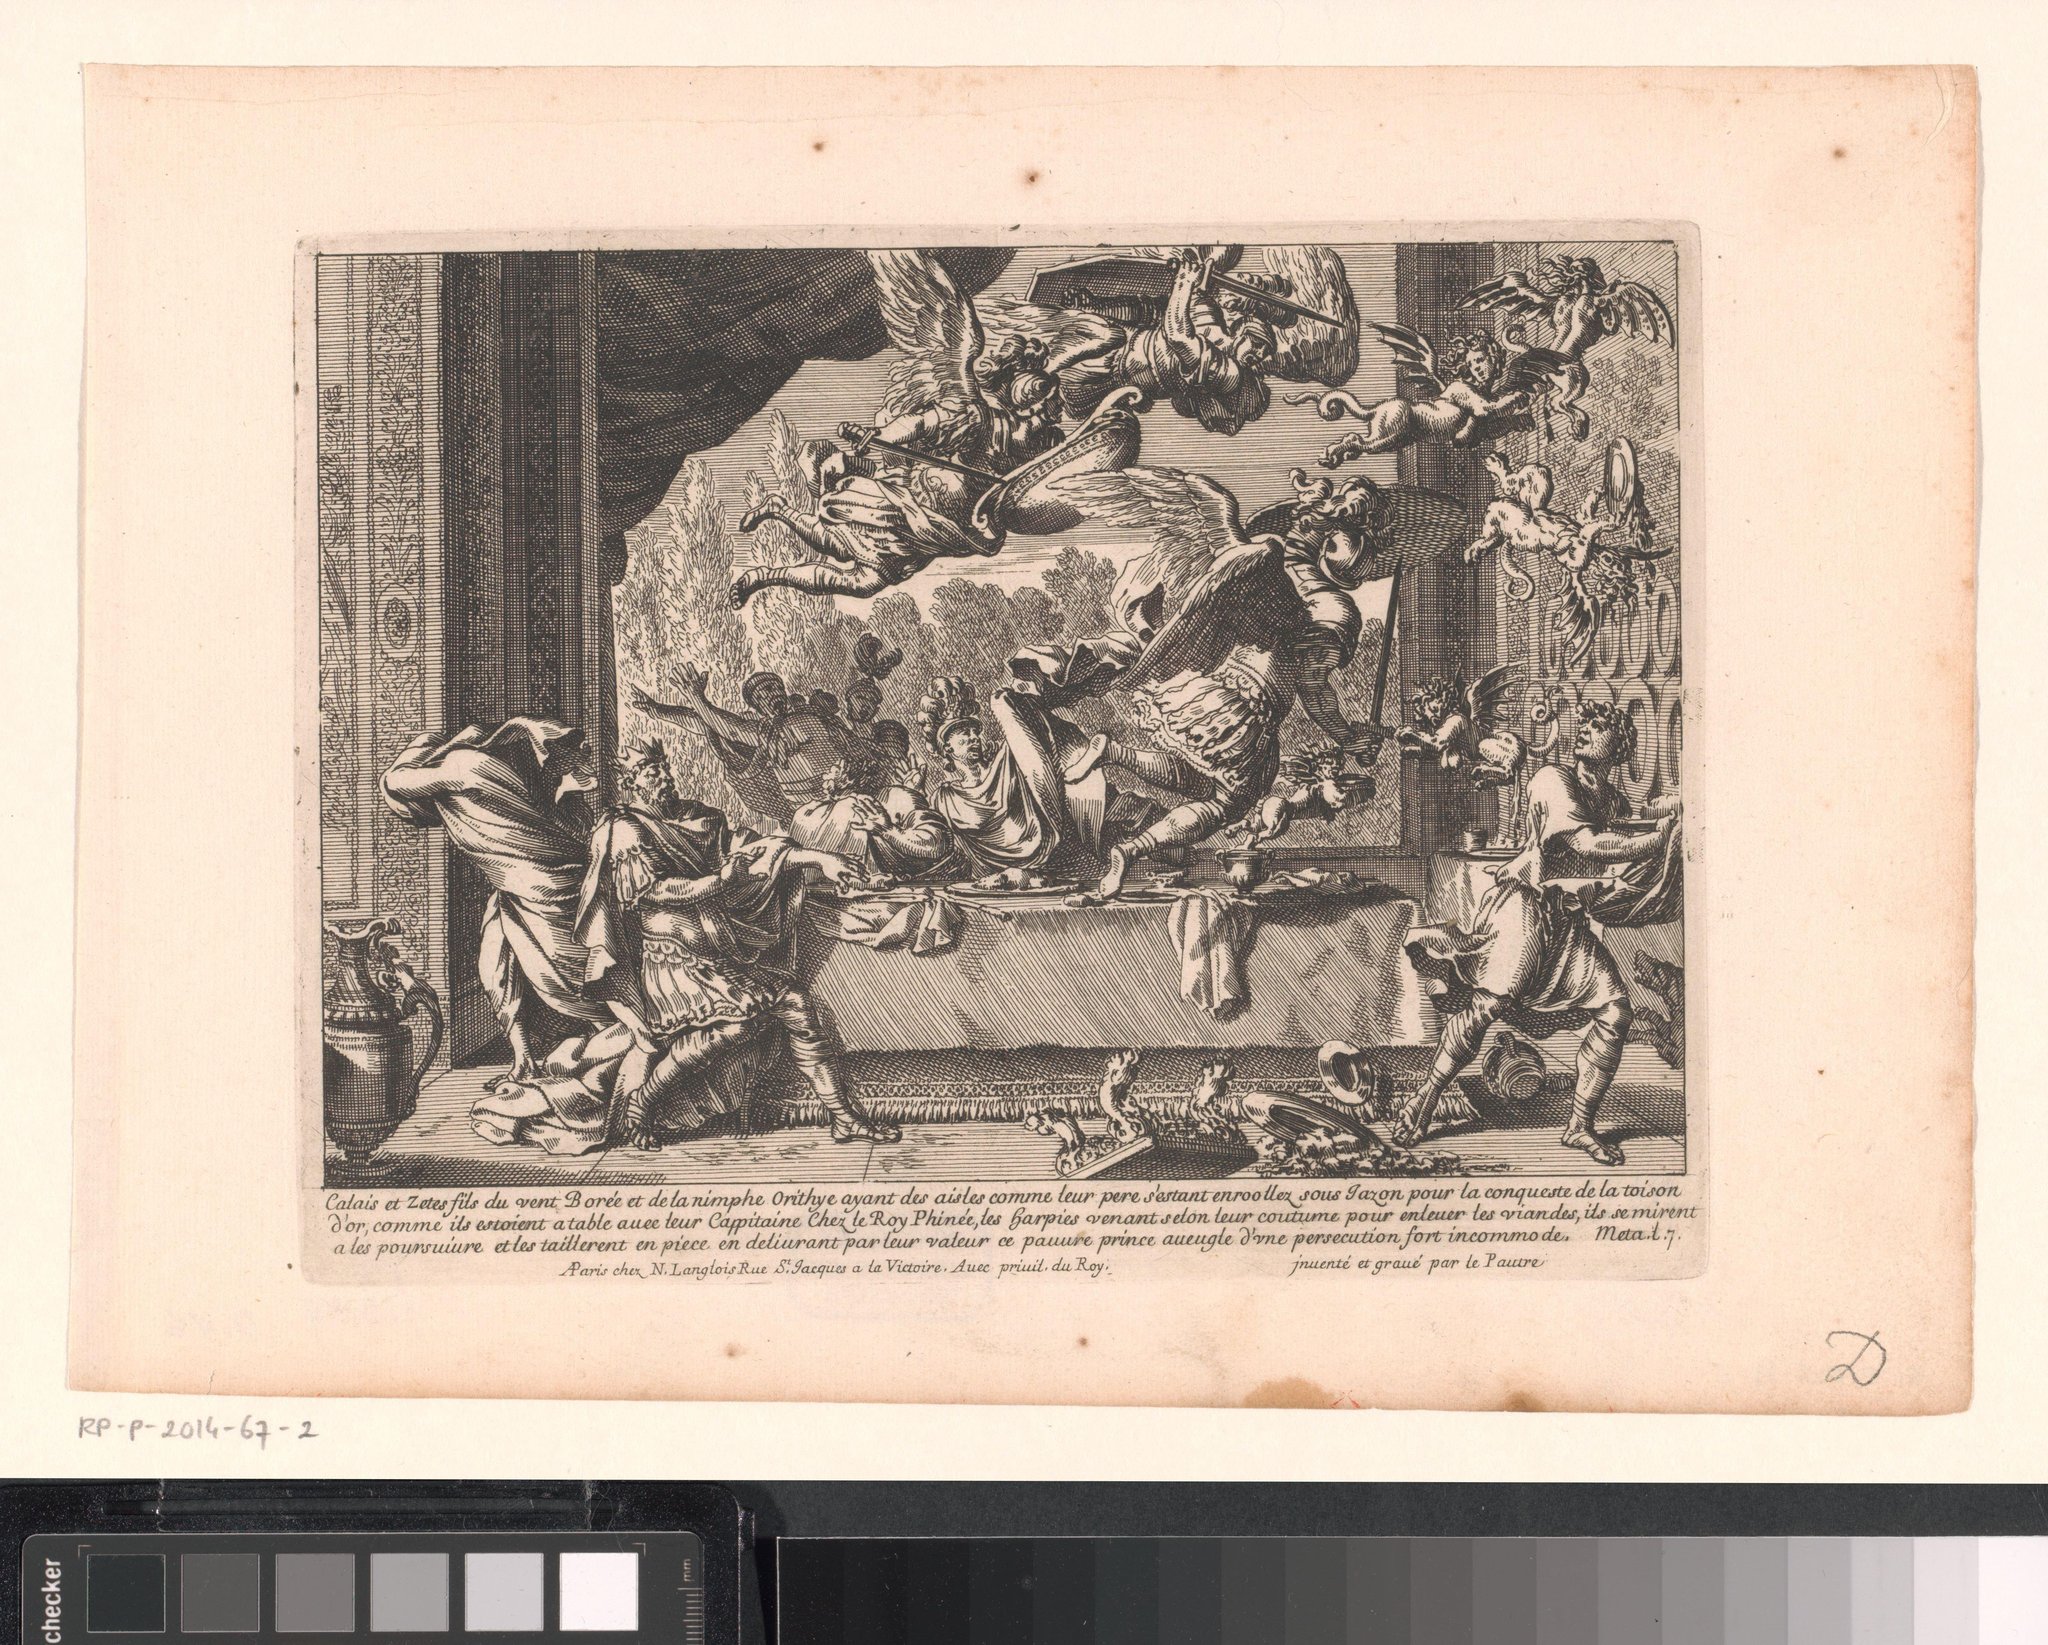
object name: print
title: Metamorfosen van Ovidius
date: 1650-1703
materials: paper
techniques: etching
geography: paris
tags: lycaon changed into a wolf: jupiter changes lycaon into a wolf as punishment for offering the god, who is sitting at table, human flesh to eat; lycaon's house is struck with lightning (ovid, metamorphoses i 237)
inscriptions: collector's mark: ‘Hinloopen’, collector's mark: Lugt 11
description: Lycaon (rechts) probeerde Jupiter (links, met adelaar) te bedriegen door diens zoon Arcas te slachten en hem als avondmaal aan te bieden, waarop Jupiter hem in een wolf verandert. Het paleis van de koning wordt getroffen door de bliksem. In de ondermarge een drieregelige toelichting op de voorstelling in het Frans.